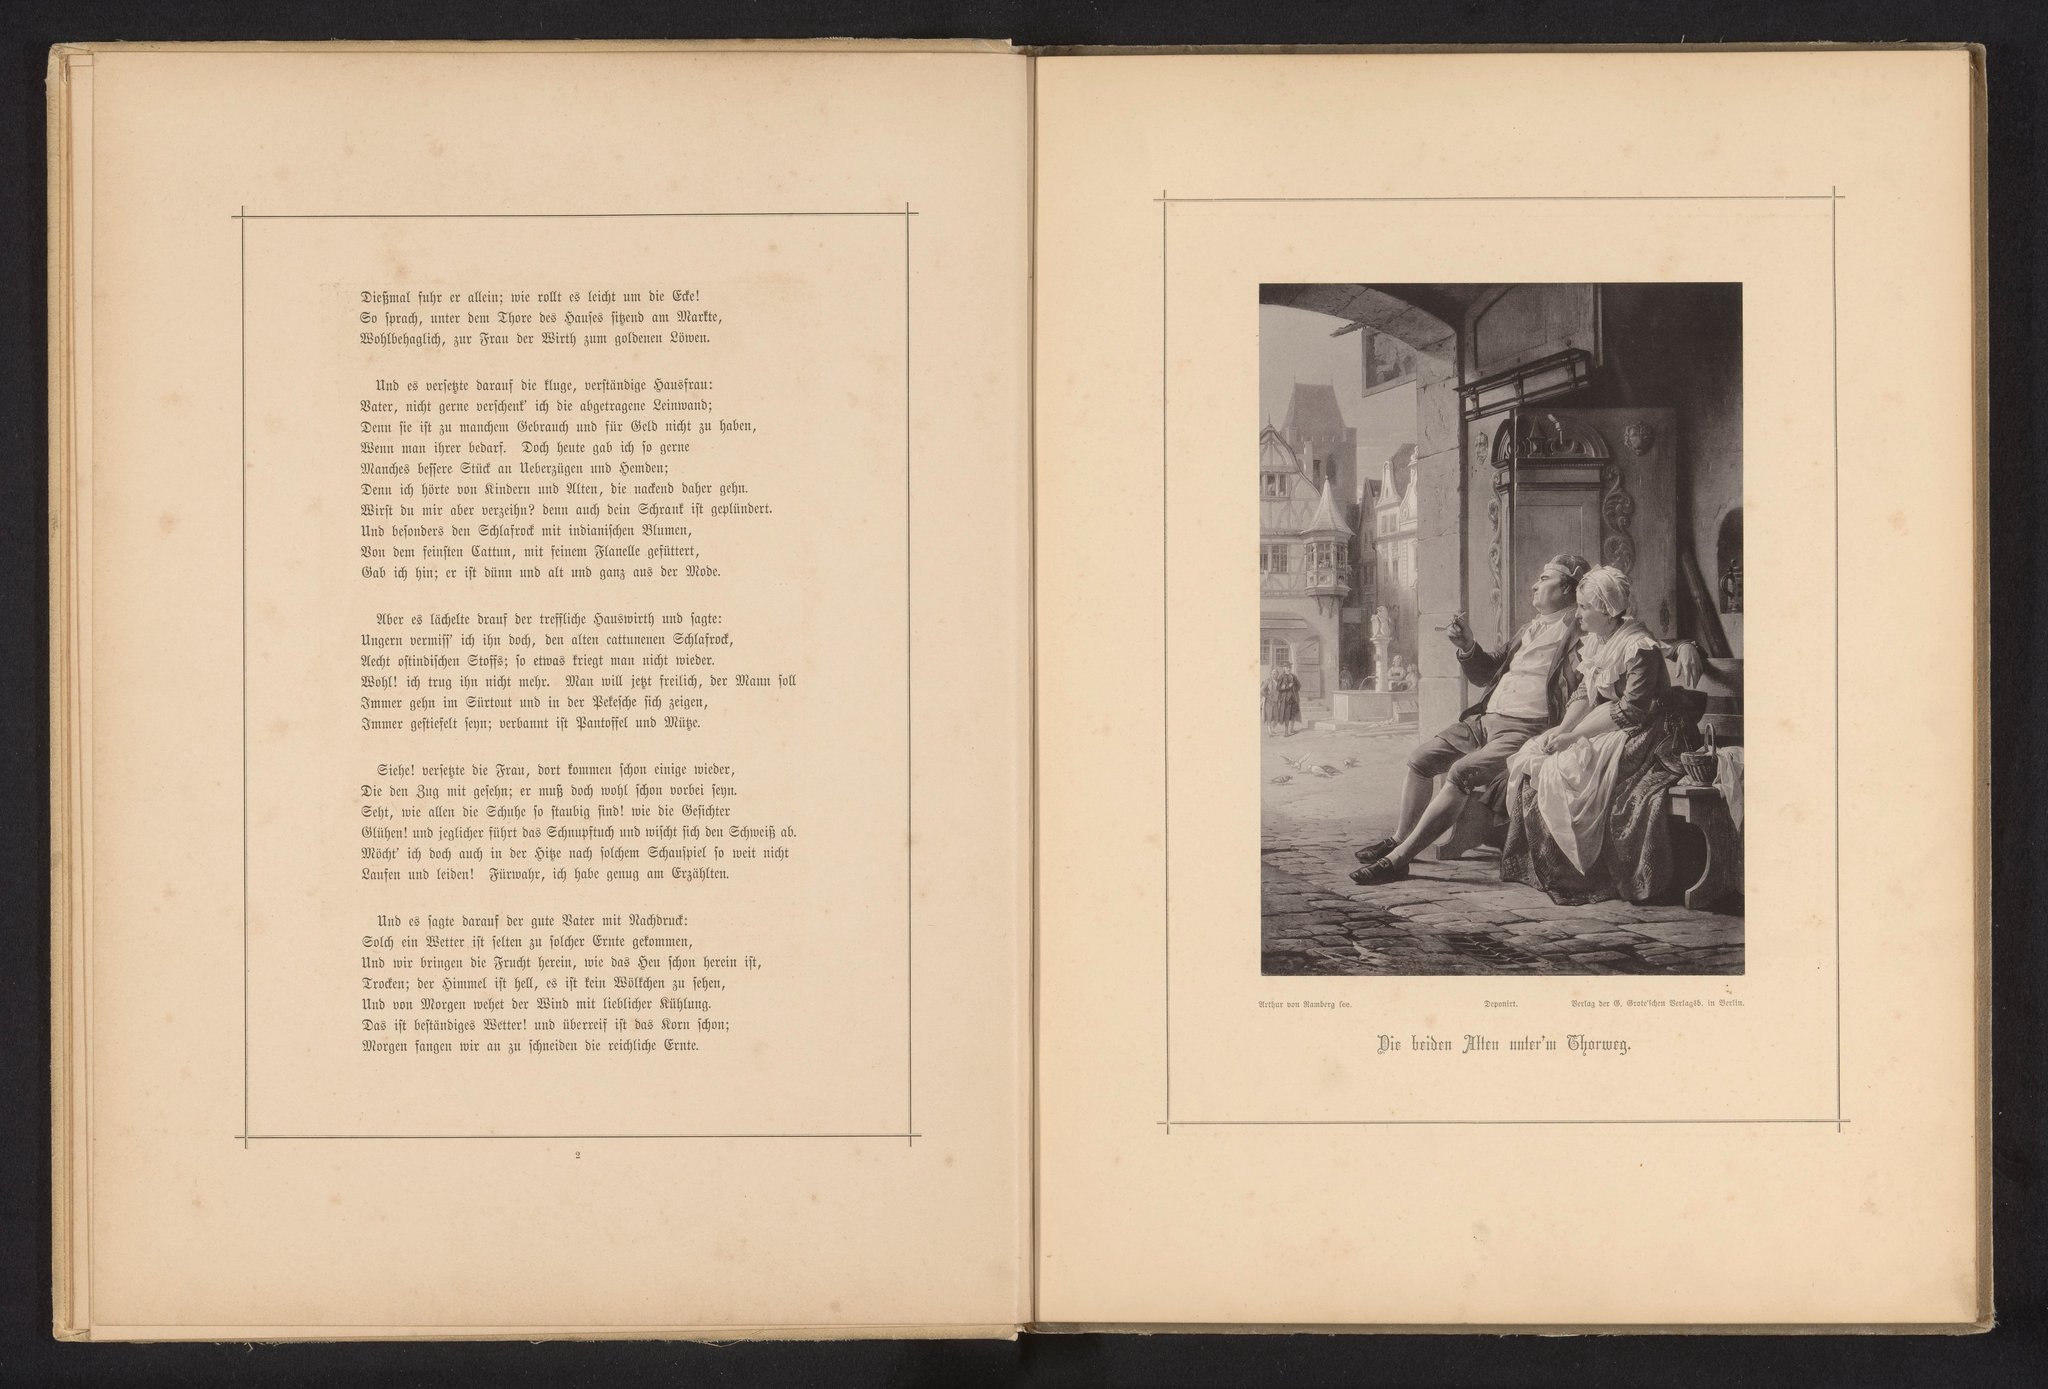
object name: page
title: Fotoreproductie van een schilderij, voorstellende de ouders van Hermann op een bank naast een plein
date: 1876-1881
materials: paper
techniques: photograph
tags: bench, marriage, married couple, 'matrimonium'